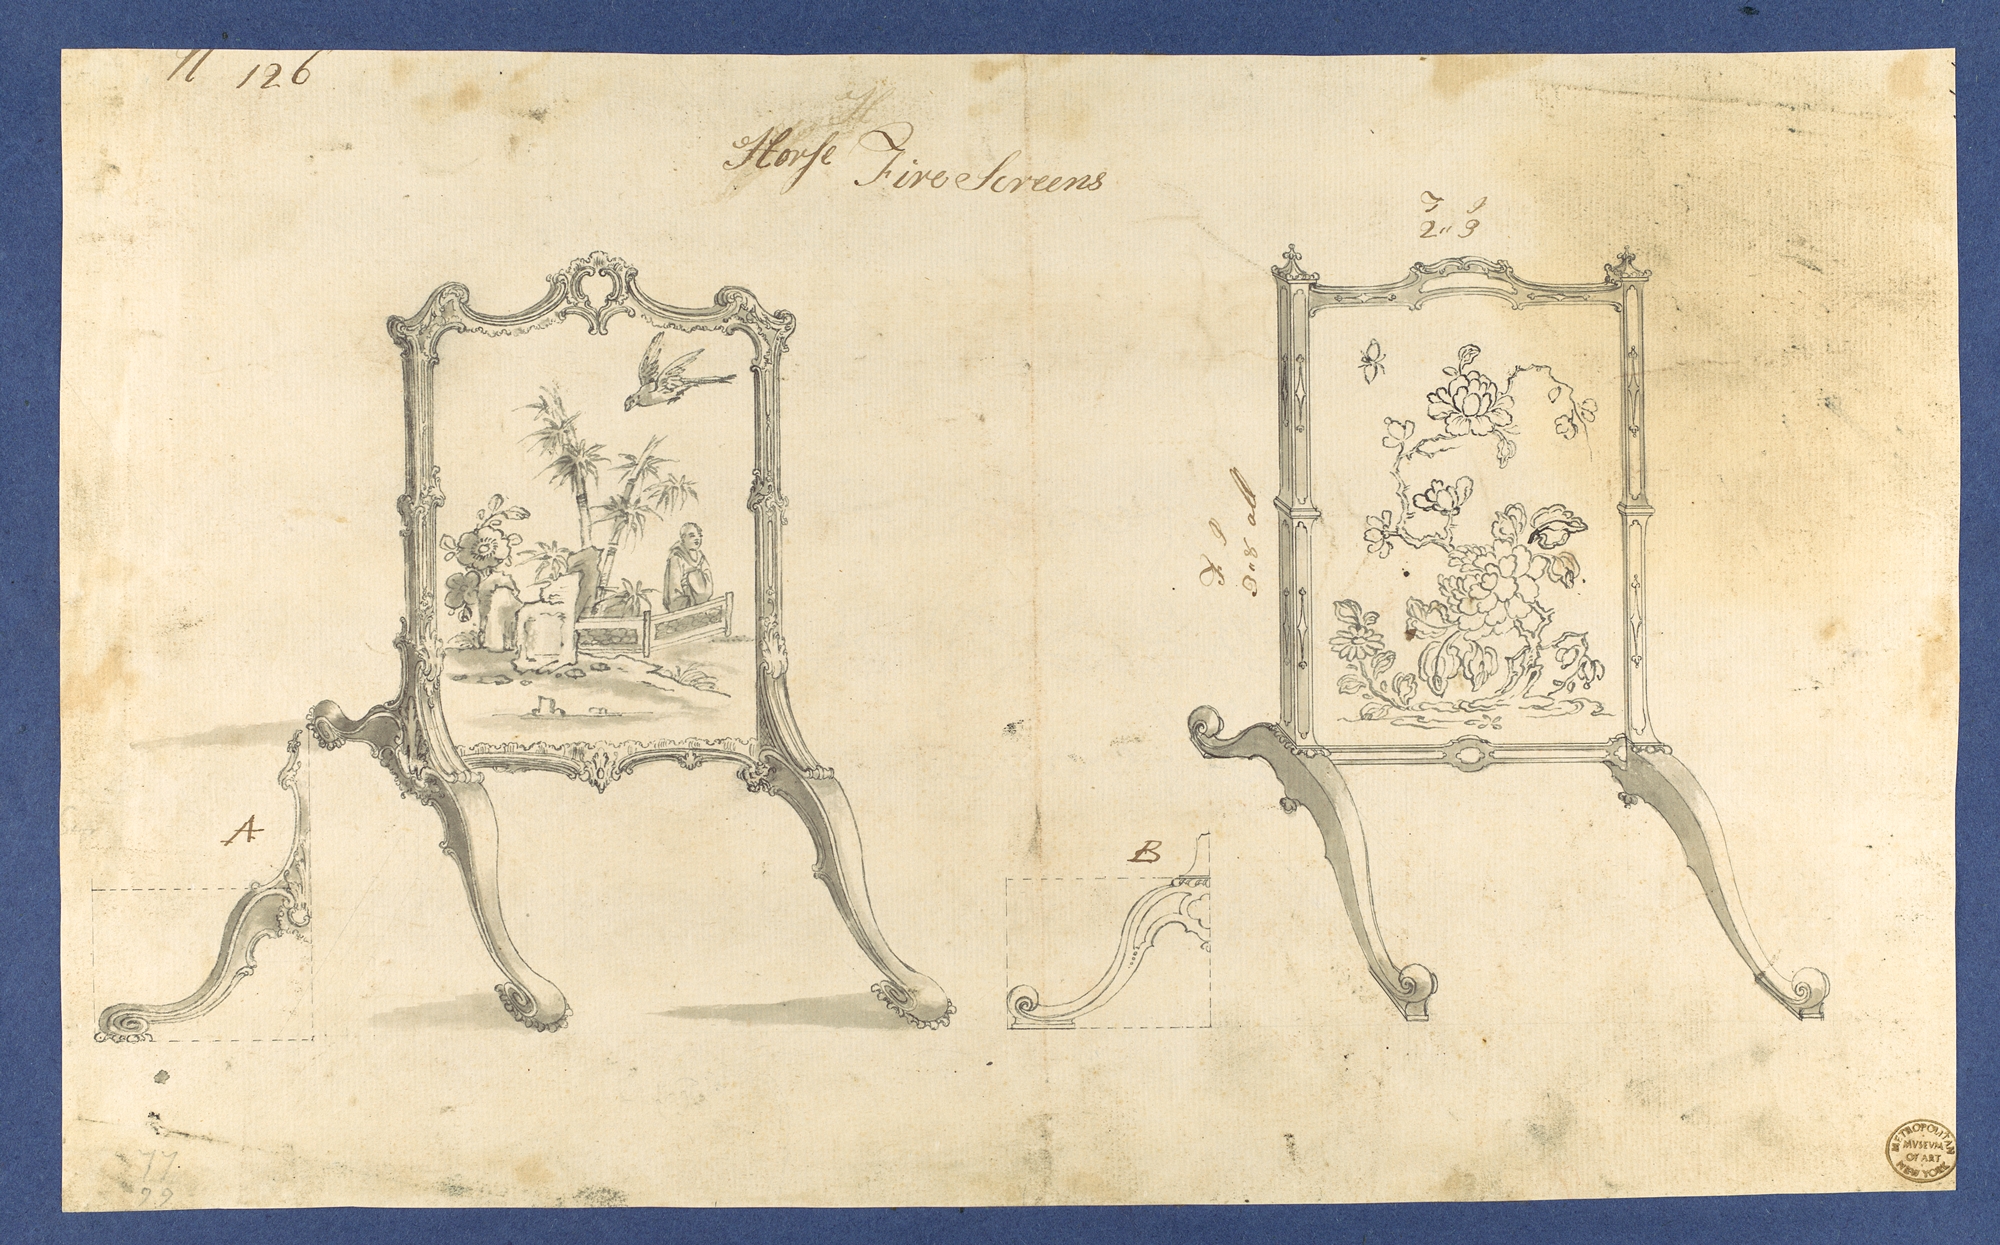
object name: drawing ornament architecture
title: Horse Fire Screens, in Chippendale Drawings, Vol. I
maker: thomas chippendale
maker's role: artist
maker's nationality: british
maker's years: 1718-1779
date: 1754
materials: ink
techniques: wash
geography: london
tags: human figures,birds,butterflies,flowers,screens